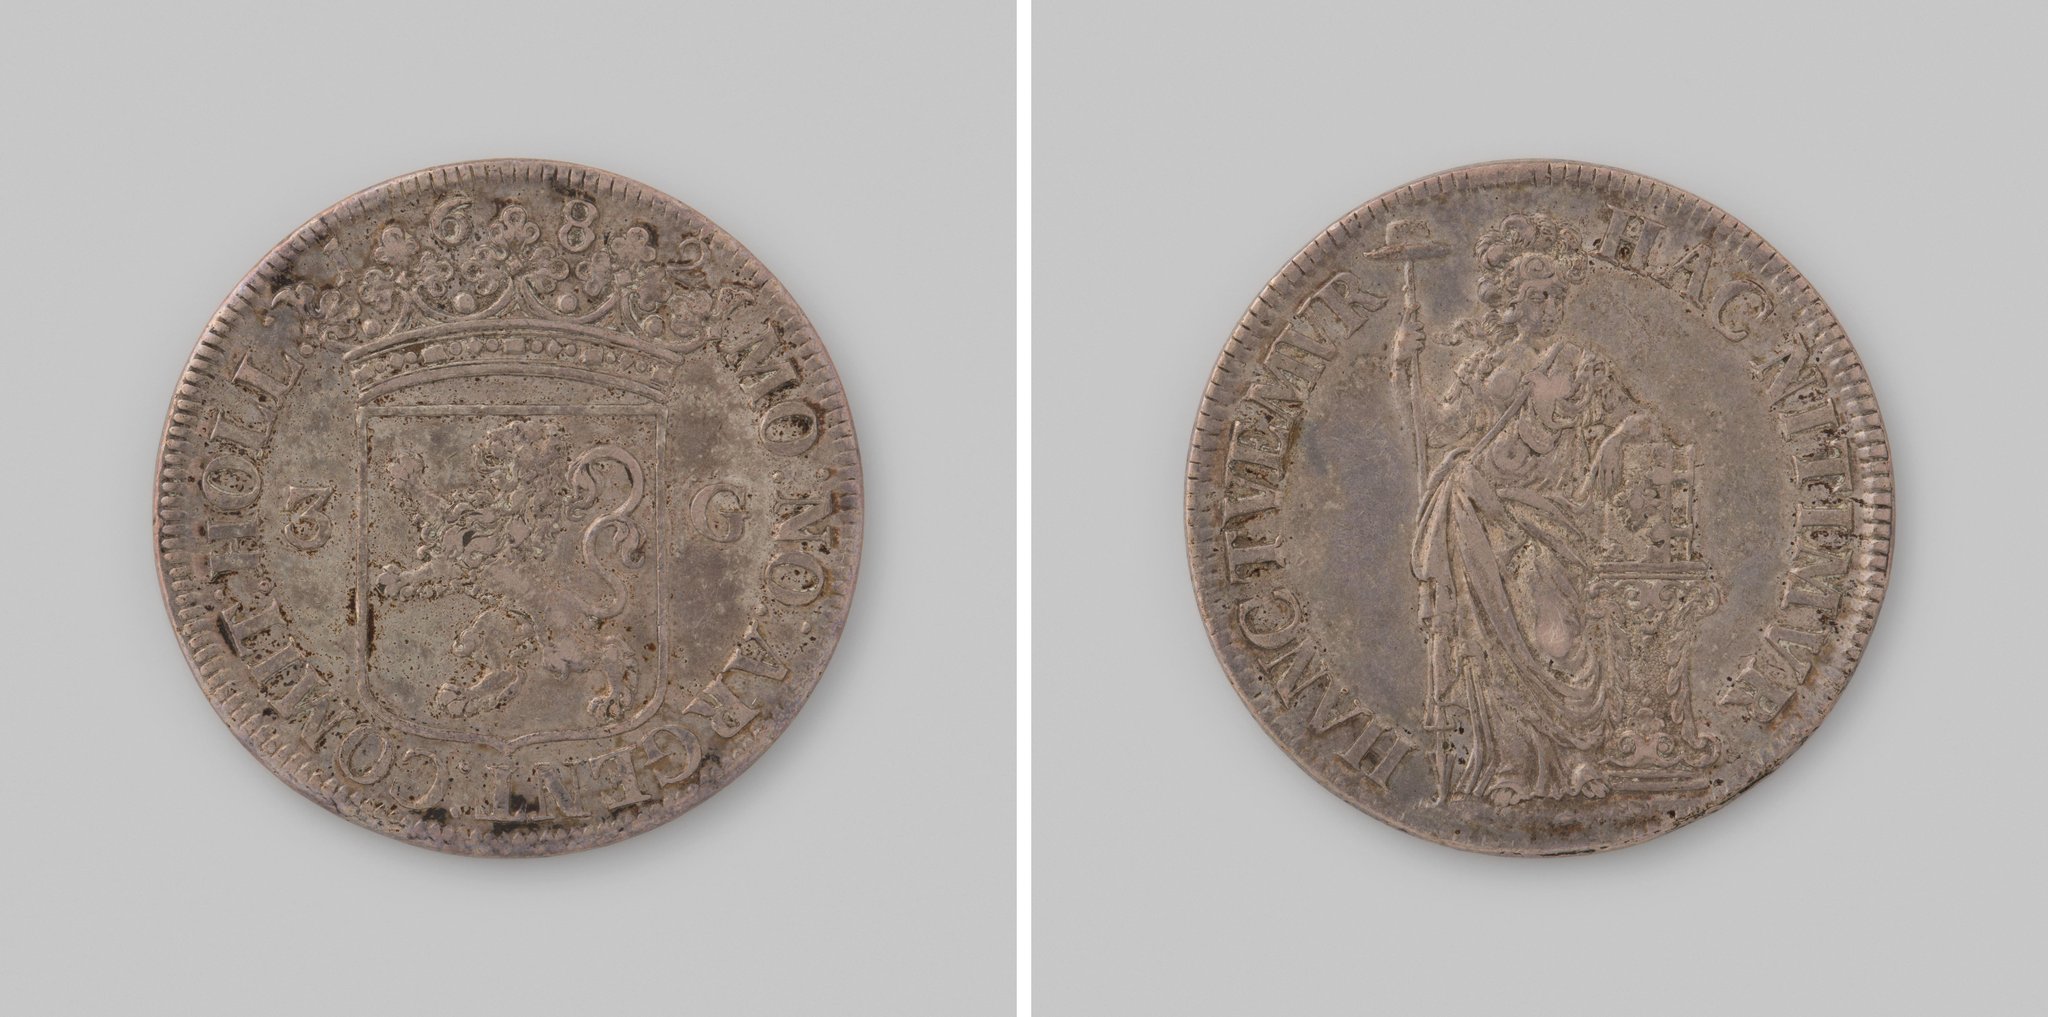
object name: coin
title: Holland, provinciale drie gulden, 1682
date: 1682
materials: silver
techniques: striking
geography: dordrecht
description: Zilveren munt. Voorzijde: tussen waarde-aanduiding gekroond wapenschild van Holland. Boven kroon jaartal. Keerzijde: staande Nederlandse maagd met in rechterhand speer, waarop hoed en met linkerhand steunend op altaar, waarop bijlbel.